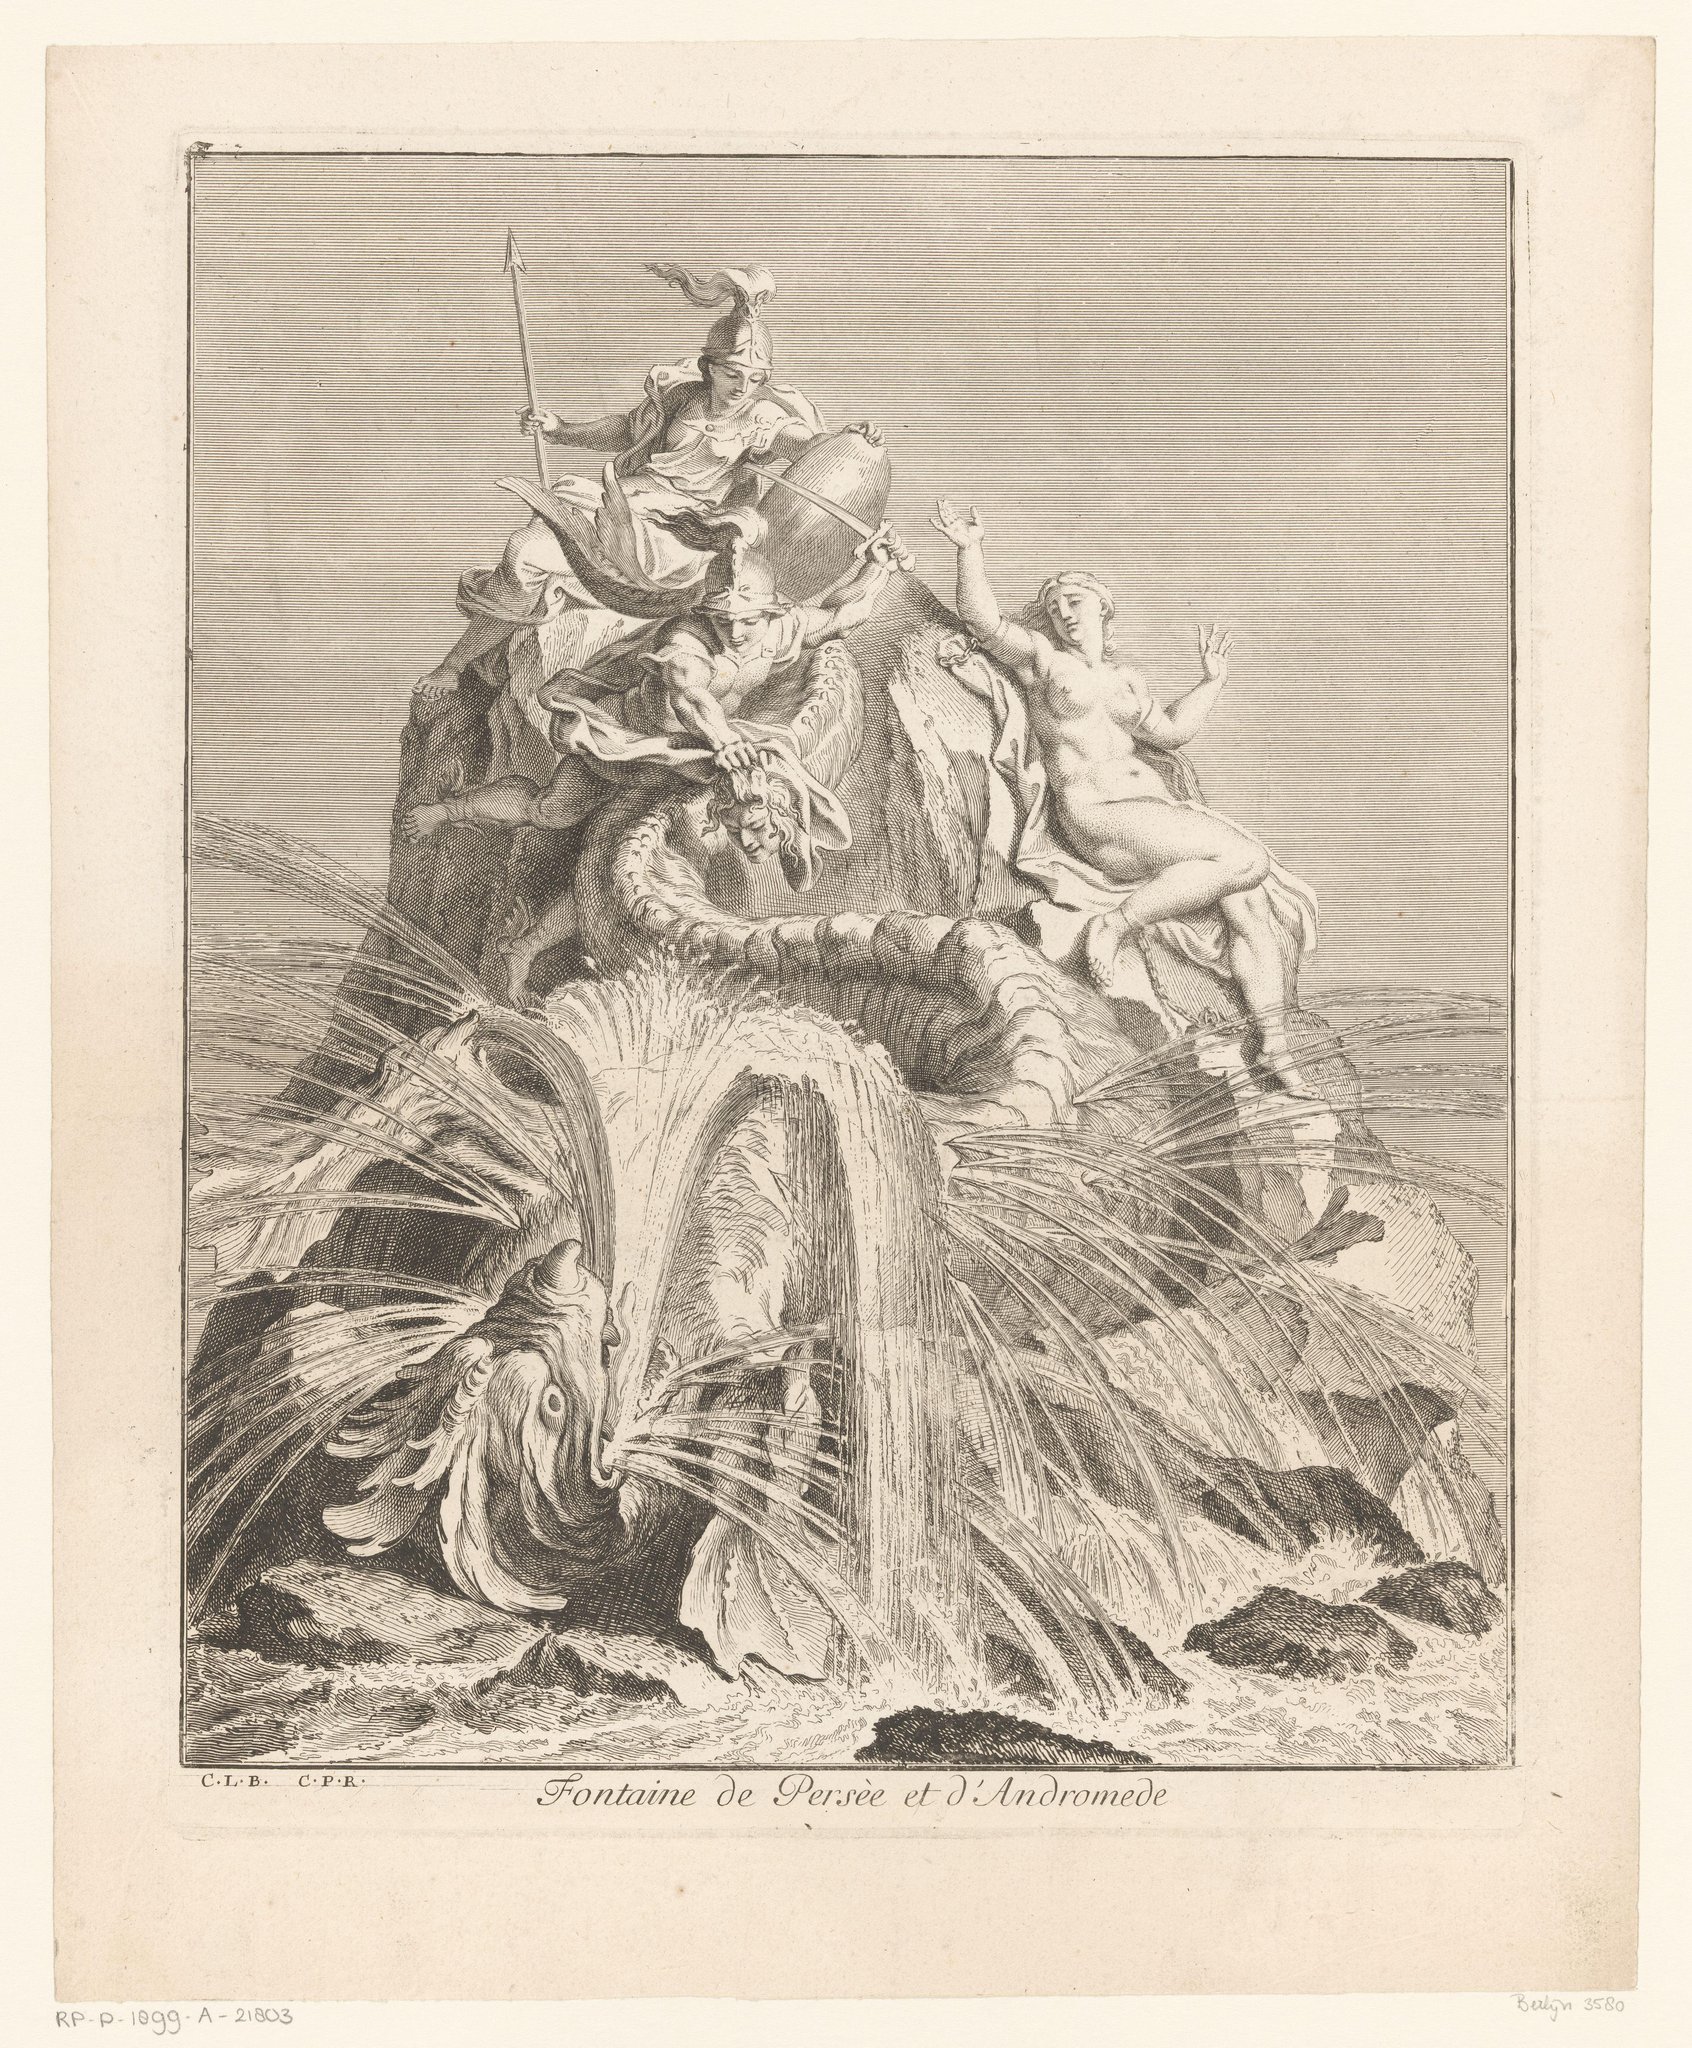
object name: print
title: Fontaine de Persèe et d'Andromede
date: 1672-1686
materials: paper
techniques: etching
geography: paris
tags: perseus kills the sea monster (or turns it into stone by showing it the gorgon's head) to release andromeda; sometimes her parents cepheus and cassiopea watch the scene, ornamental fountain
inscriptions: collector's mark: Lugt 2228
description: Een fontein met Perseus en Andromeda. Perseus toont de draak het hoofd van Medusa. Achter hem zit Minerva. Rechts zit Andromeda geketend aan de rots.